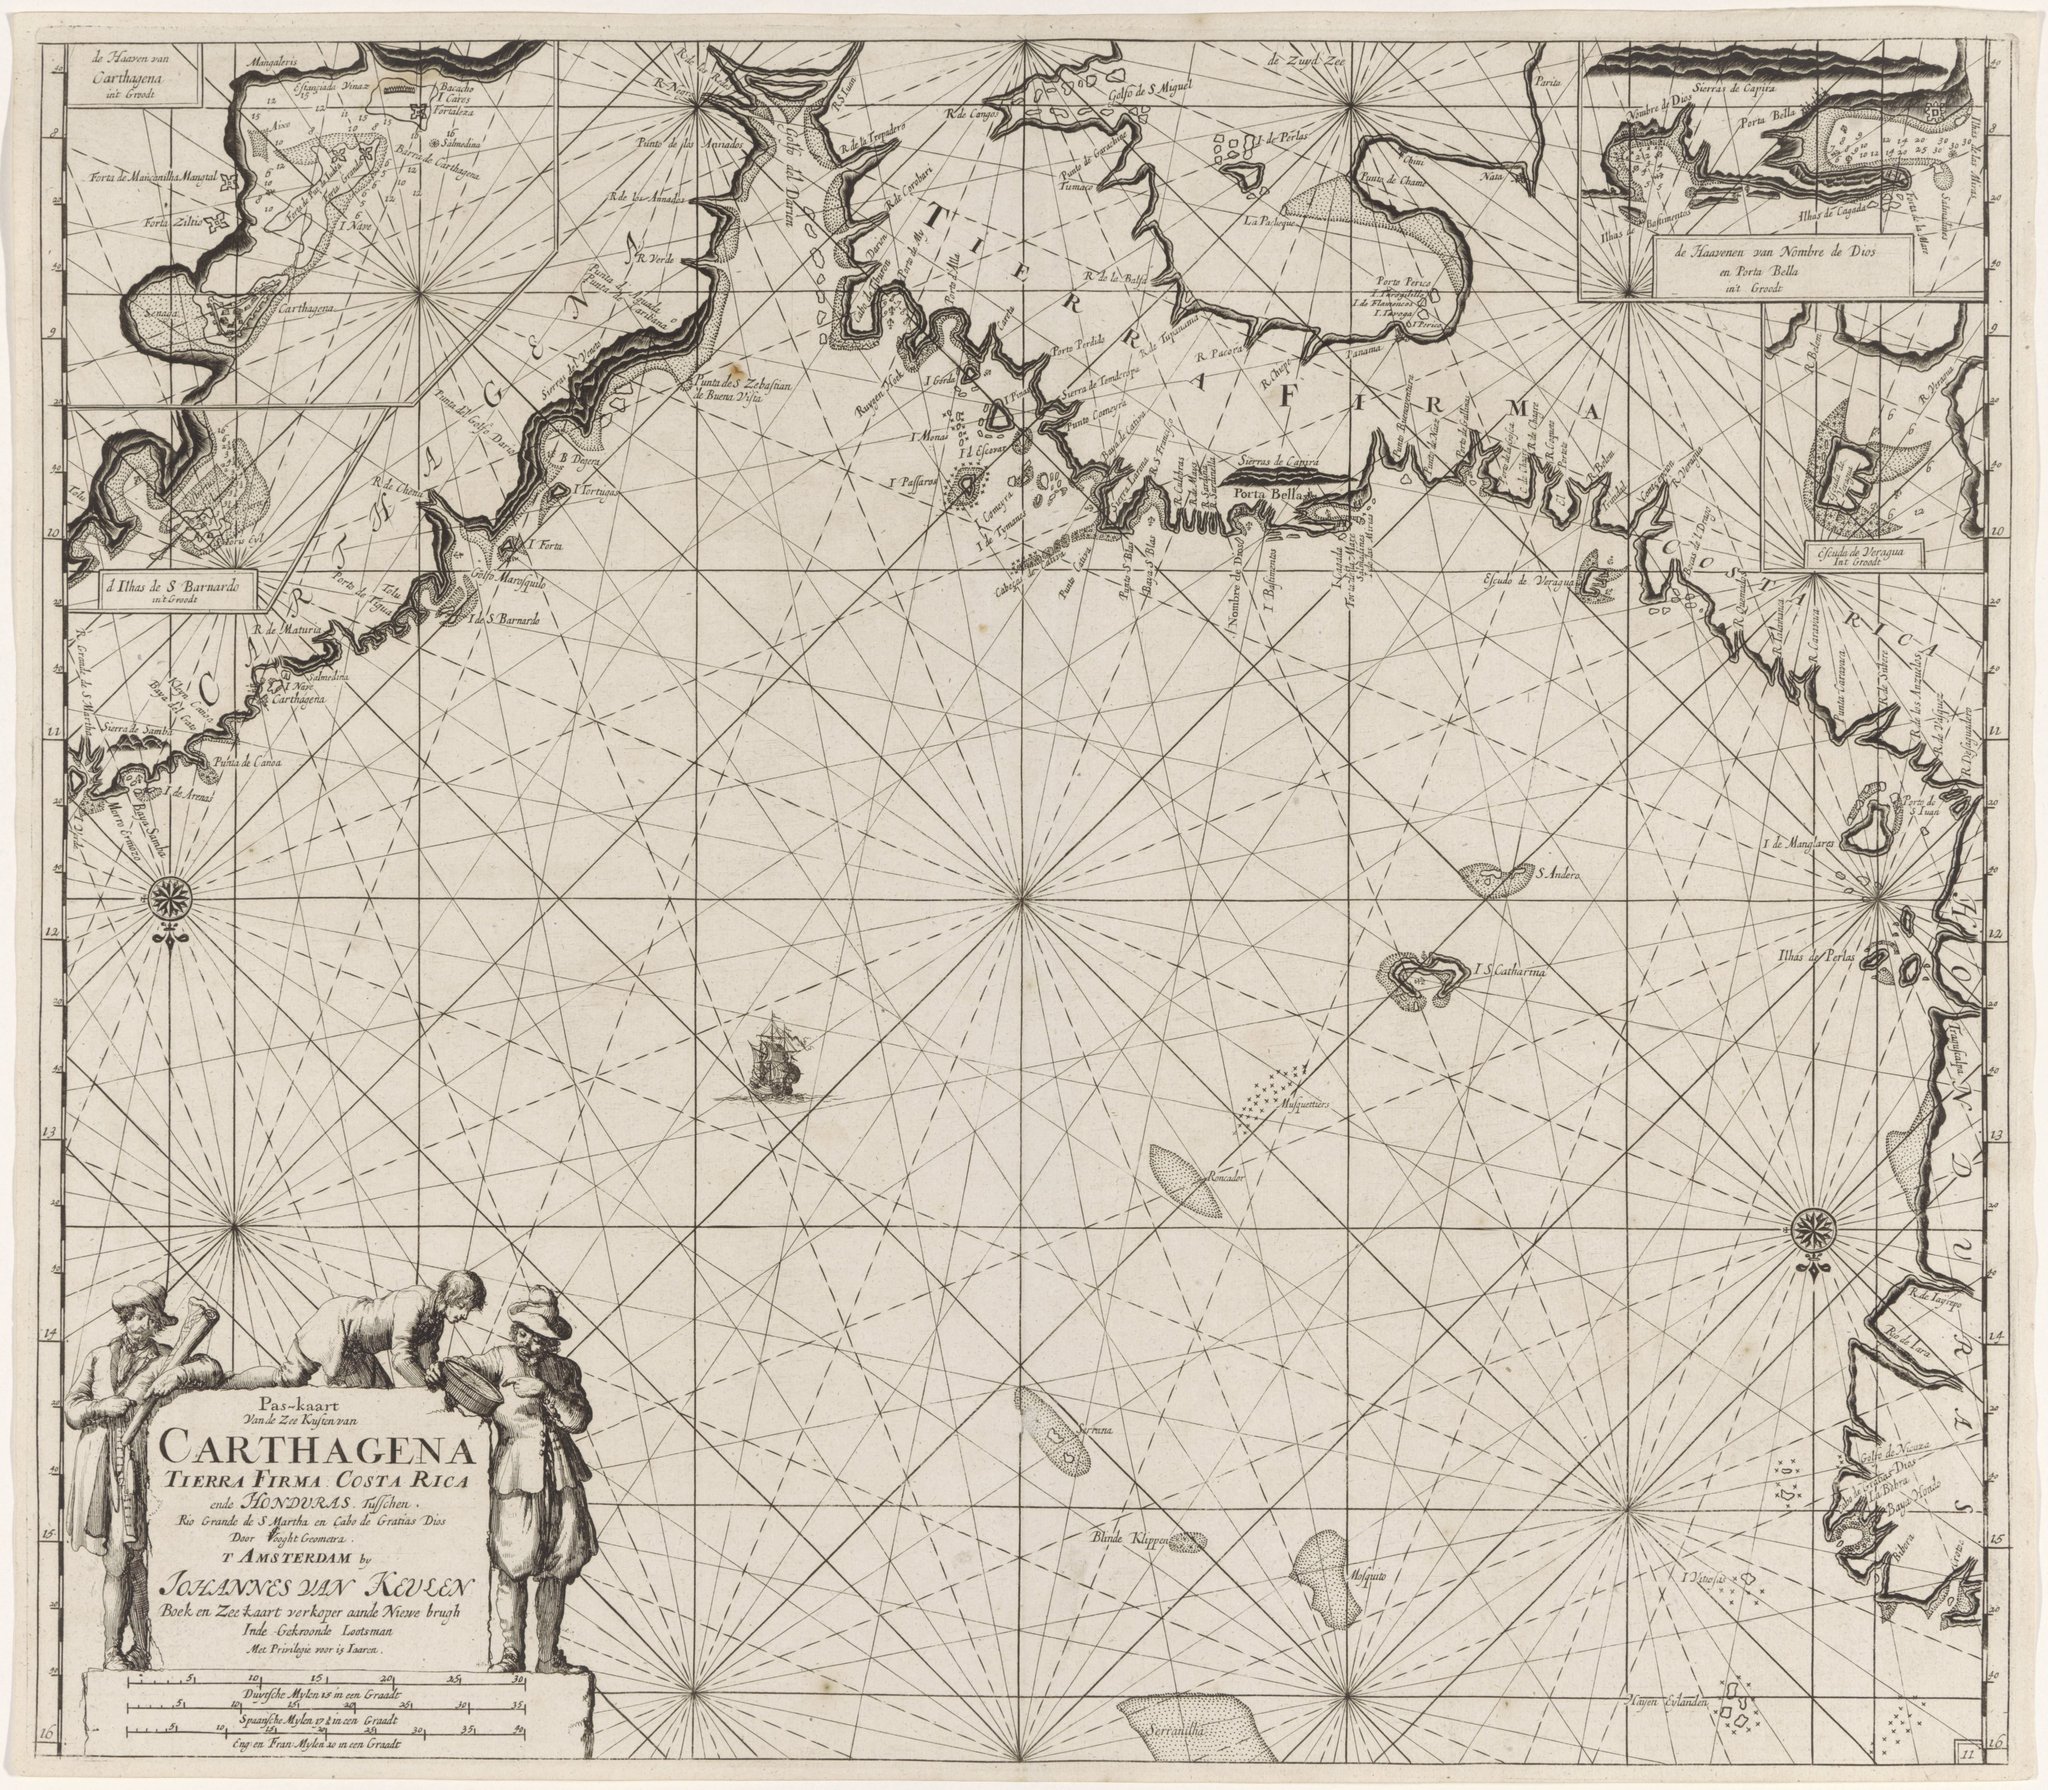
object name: print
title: Paskaart van de kusten Colombia, Panama, Costa Rica en Honduras, met een inzetkaart van Carthagena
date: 1684-1799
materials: paper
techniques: engraving, etching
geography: amsterdam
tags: sailing-ship, sailing-boat, maps, atlases, compass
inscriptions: collector's mark: Lugt 2228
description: Paskaart van de kusten Colombia, Panama, Costa Rica en Honduras, met drie een inzetkaarten, waarvan een van Carthagena. Met twee kompasrozen, het Noorden ligt onder. Linksonder de titel, het adres van de uitgever en de schaalverdeling, weergegeven in Duitse, Spaanse en Engelse of Franse mijlen (schaal: c. 1:1.900.000). De gegevens zijn geflankeerd door twee mannen die op een kompas kijken en een man met een opgerolde kaart.